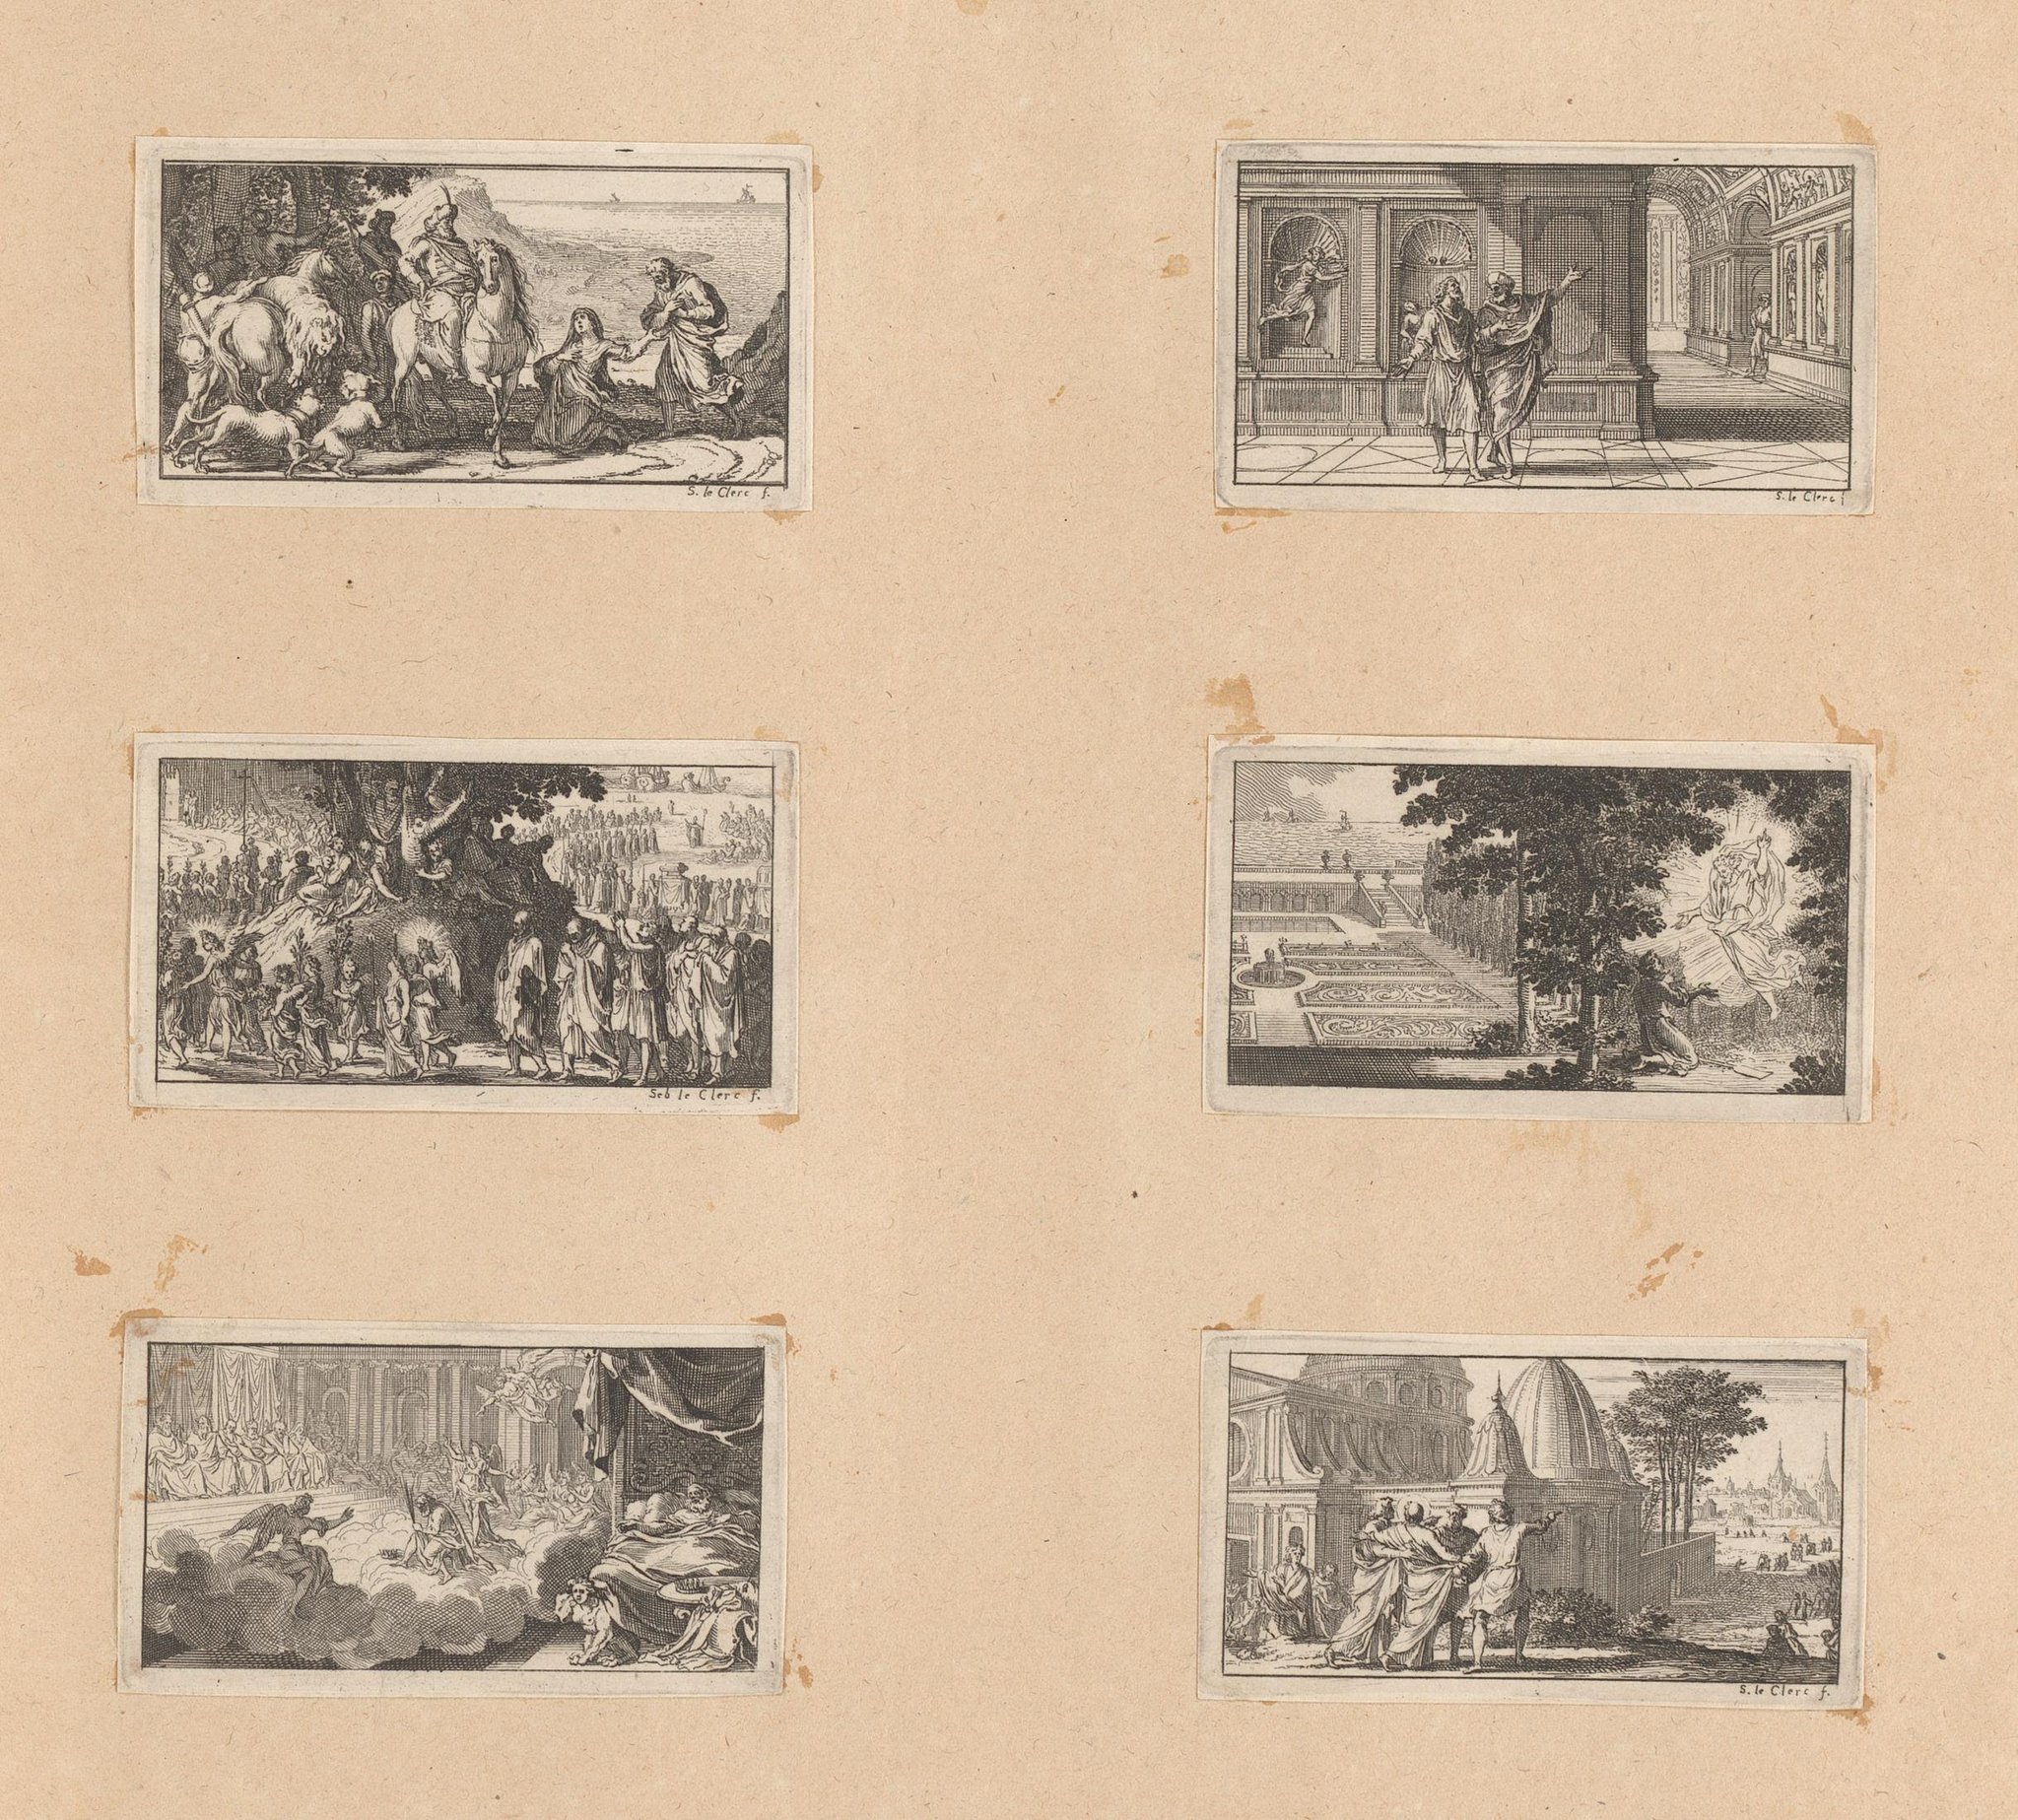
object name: album leaf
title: Zes prenten met voorstellingen van de H. Paulinus van Nola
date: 1686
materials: paper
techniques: etching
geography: paris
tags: saints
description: Prenten uit: Perrault, Charles. Saint Paulin evesque de Nole. Parijs: J.B. Coignard, 1686.